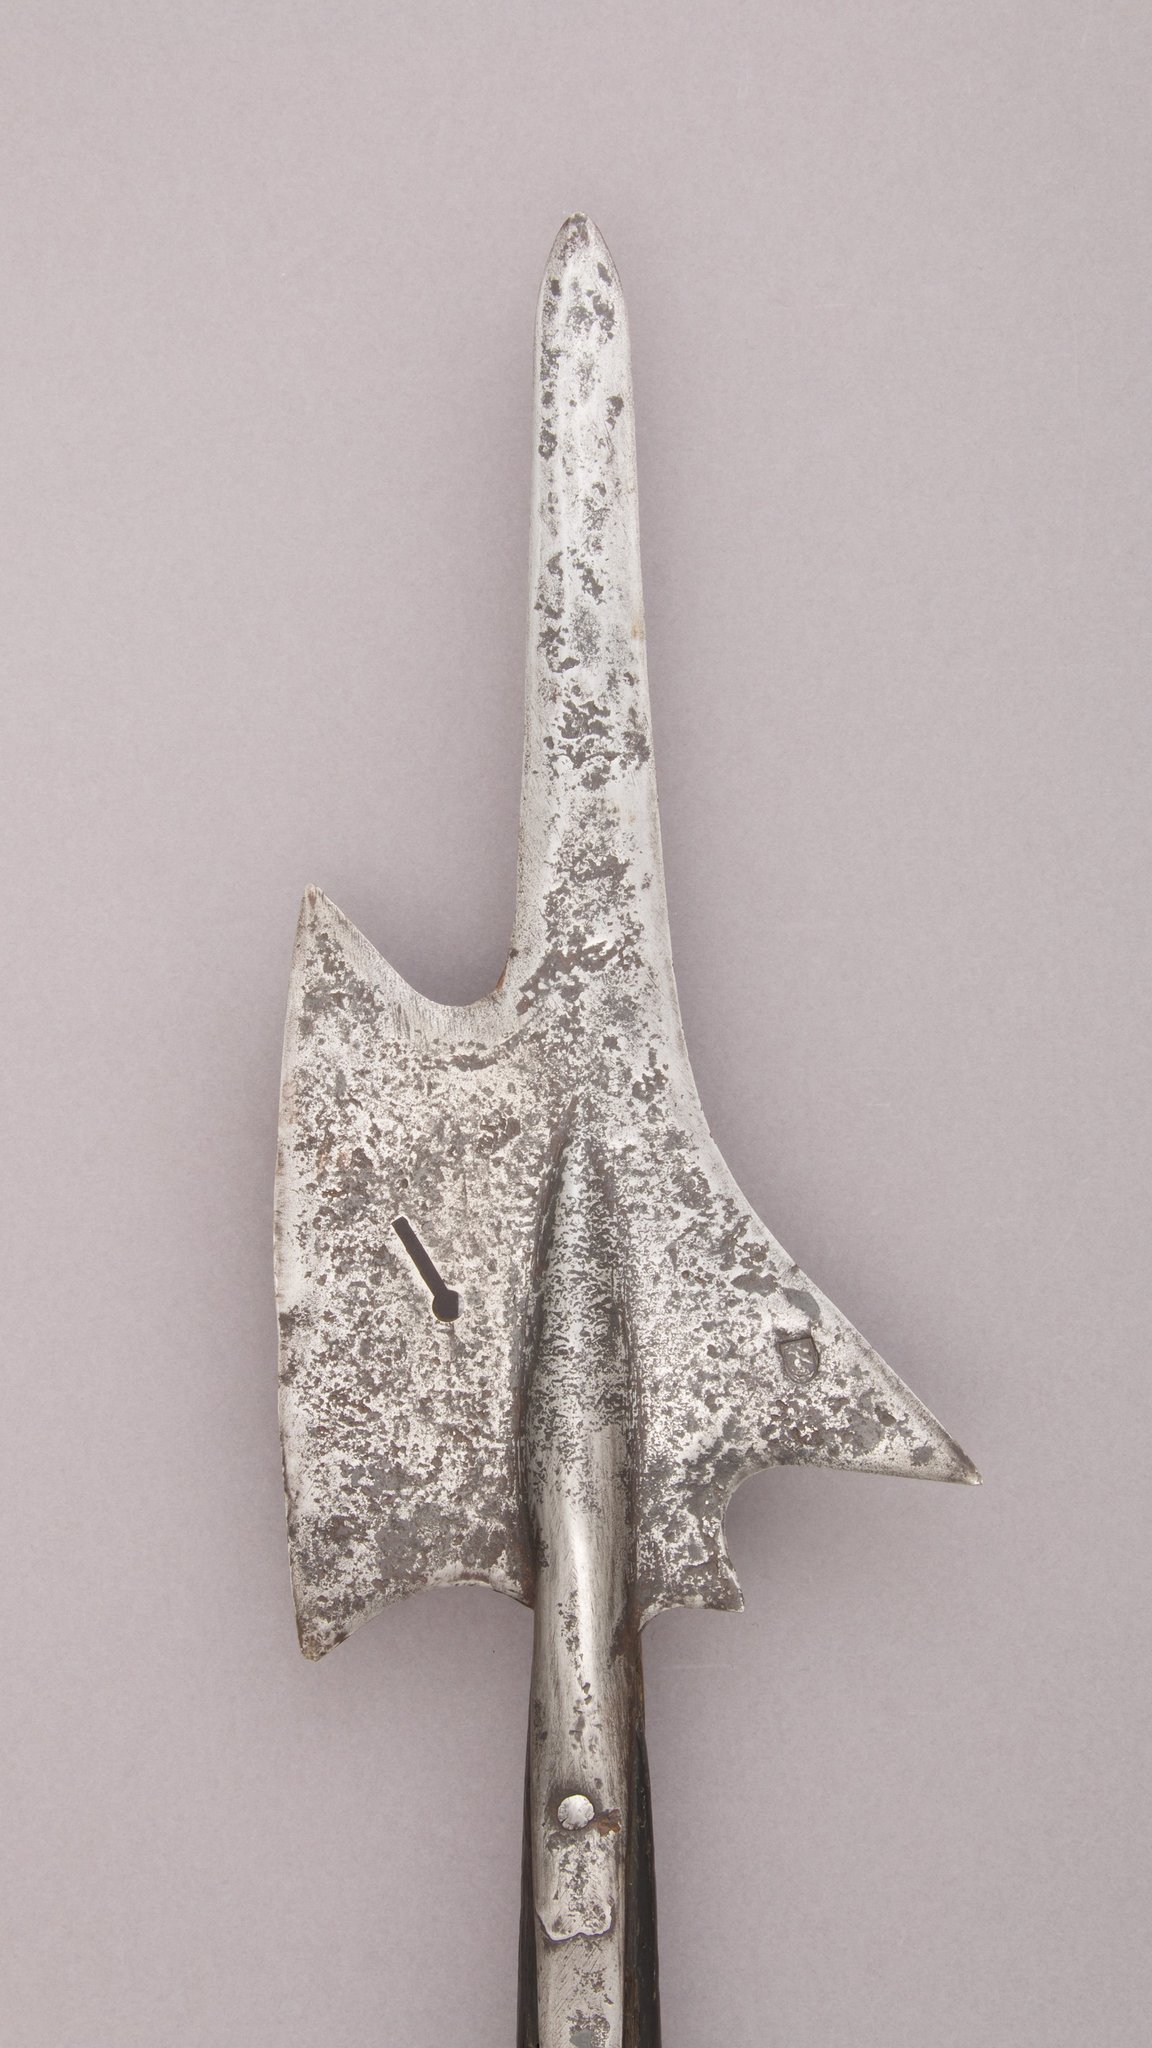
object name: halberd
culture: german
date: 1900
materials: steel, wood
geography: germany